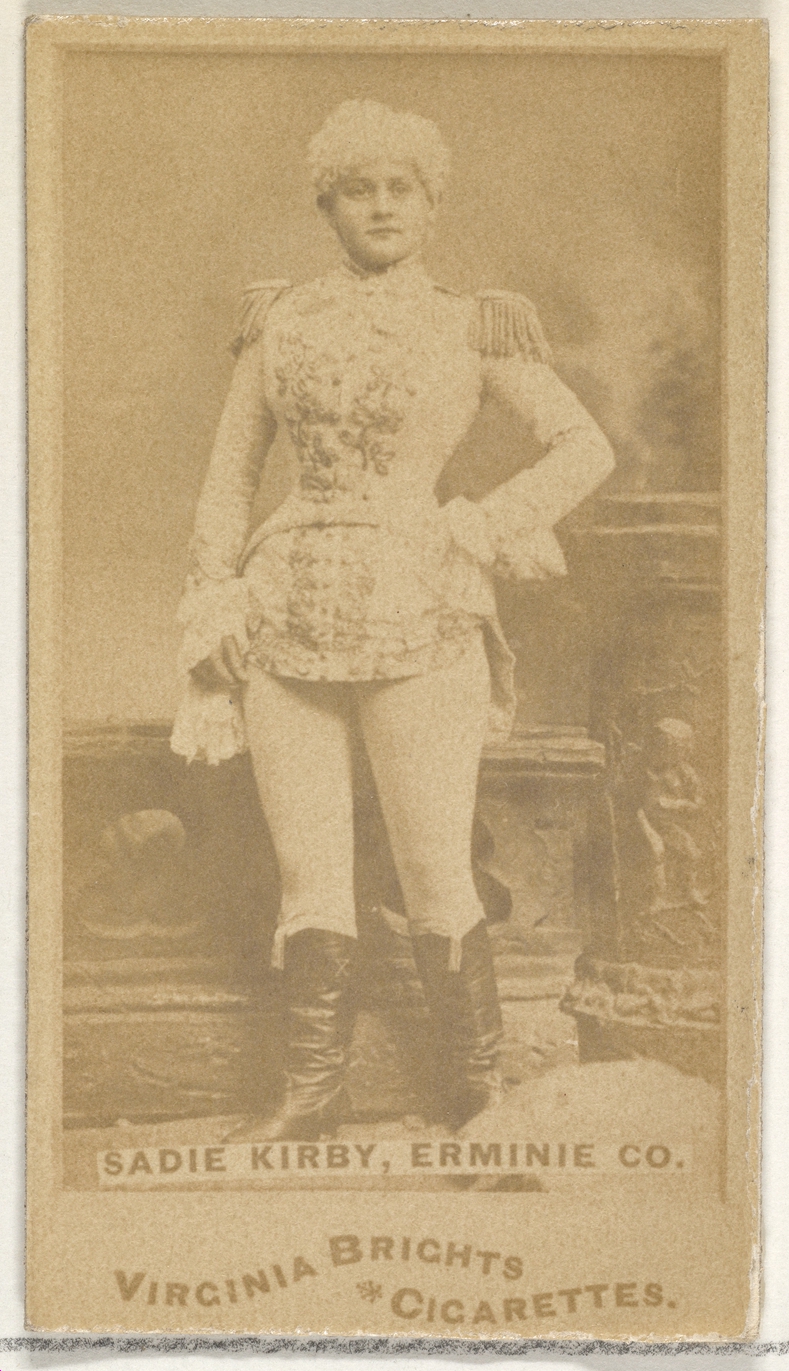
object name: photograph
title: Sadie Kirby, Erminie Co., from the Actors and Actresses series (N45, Type 1) for Virginia Brights Cigarettes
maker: allen & ginter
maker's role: publisher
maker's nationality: american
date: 1888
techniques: albumen silver print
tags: portraits,women,actresses